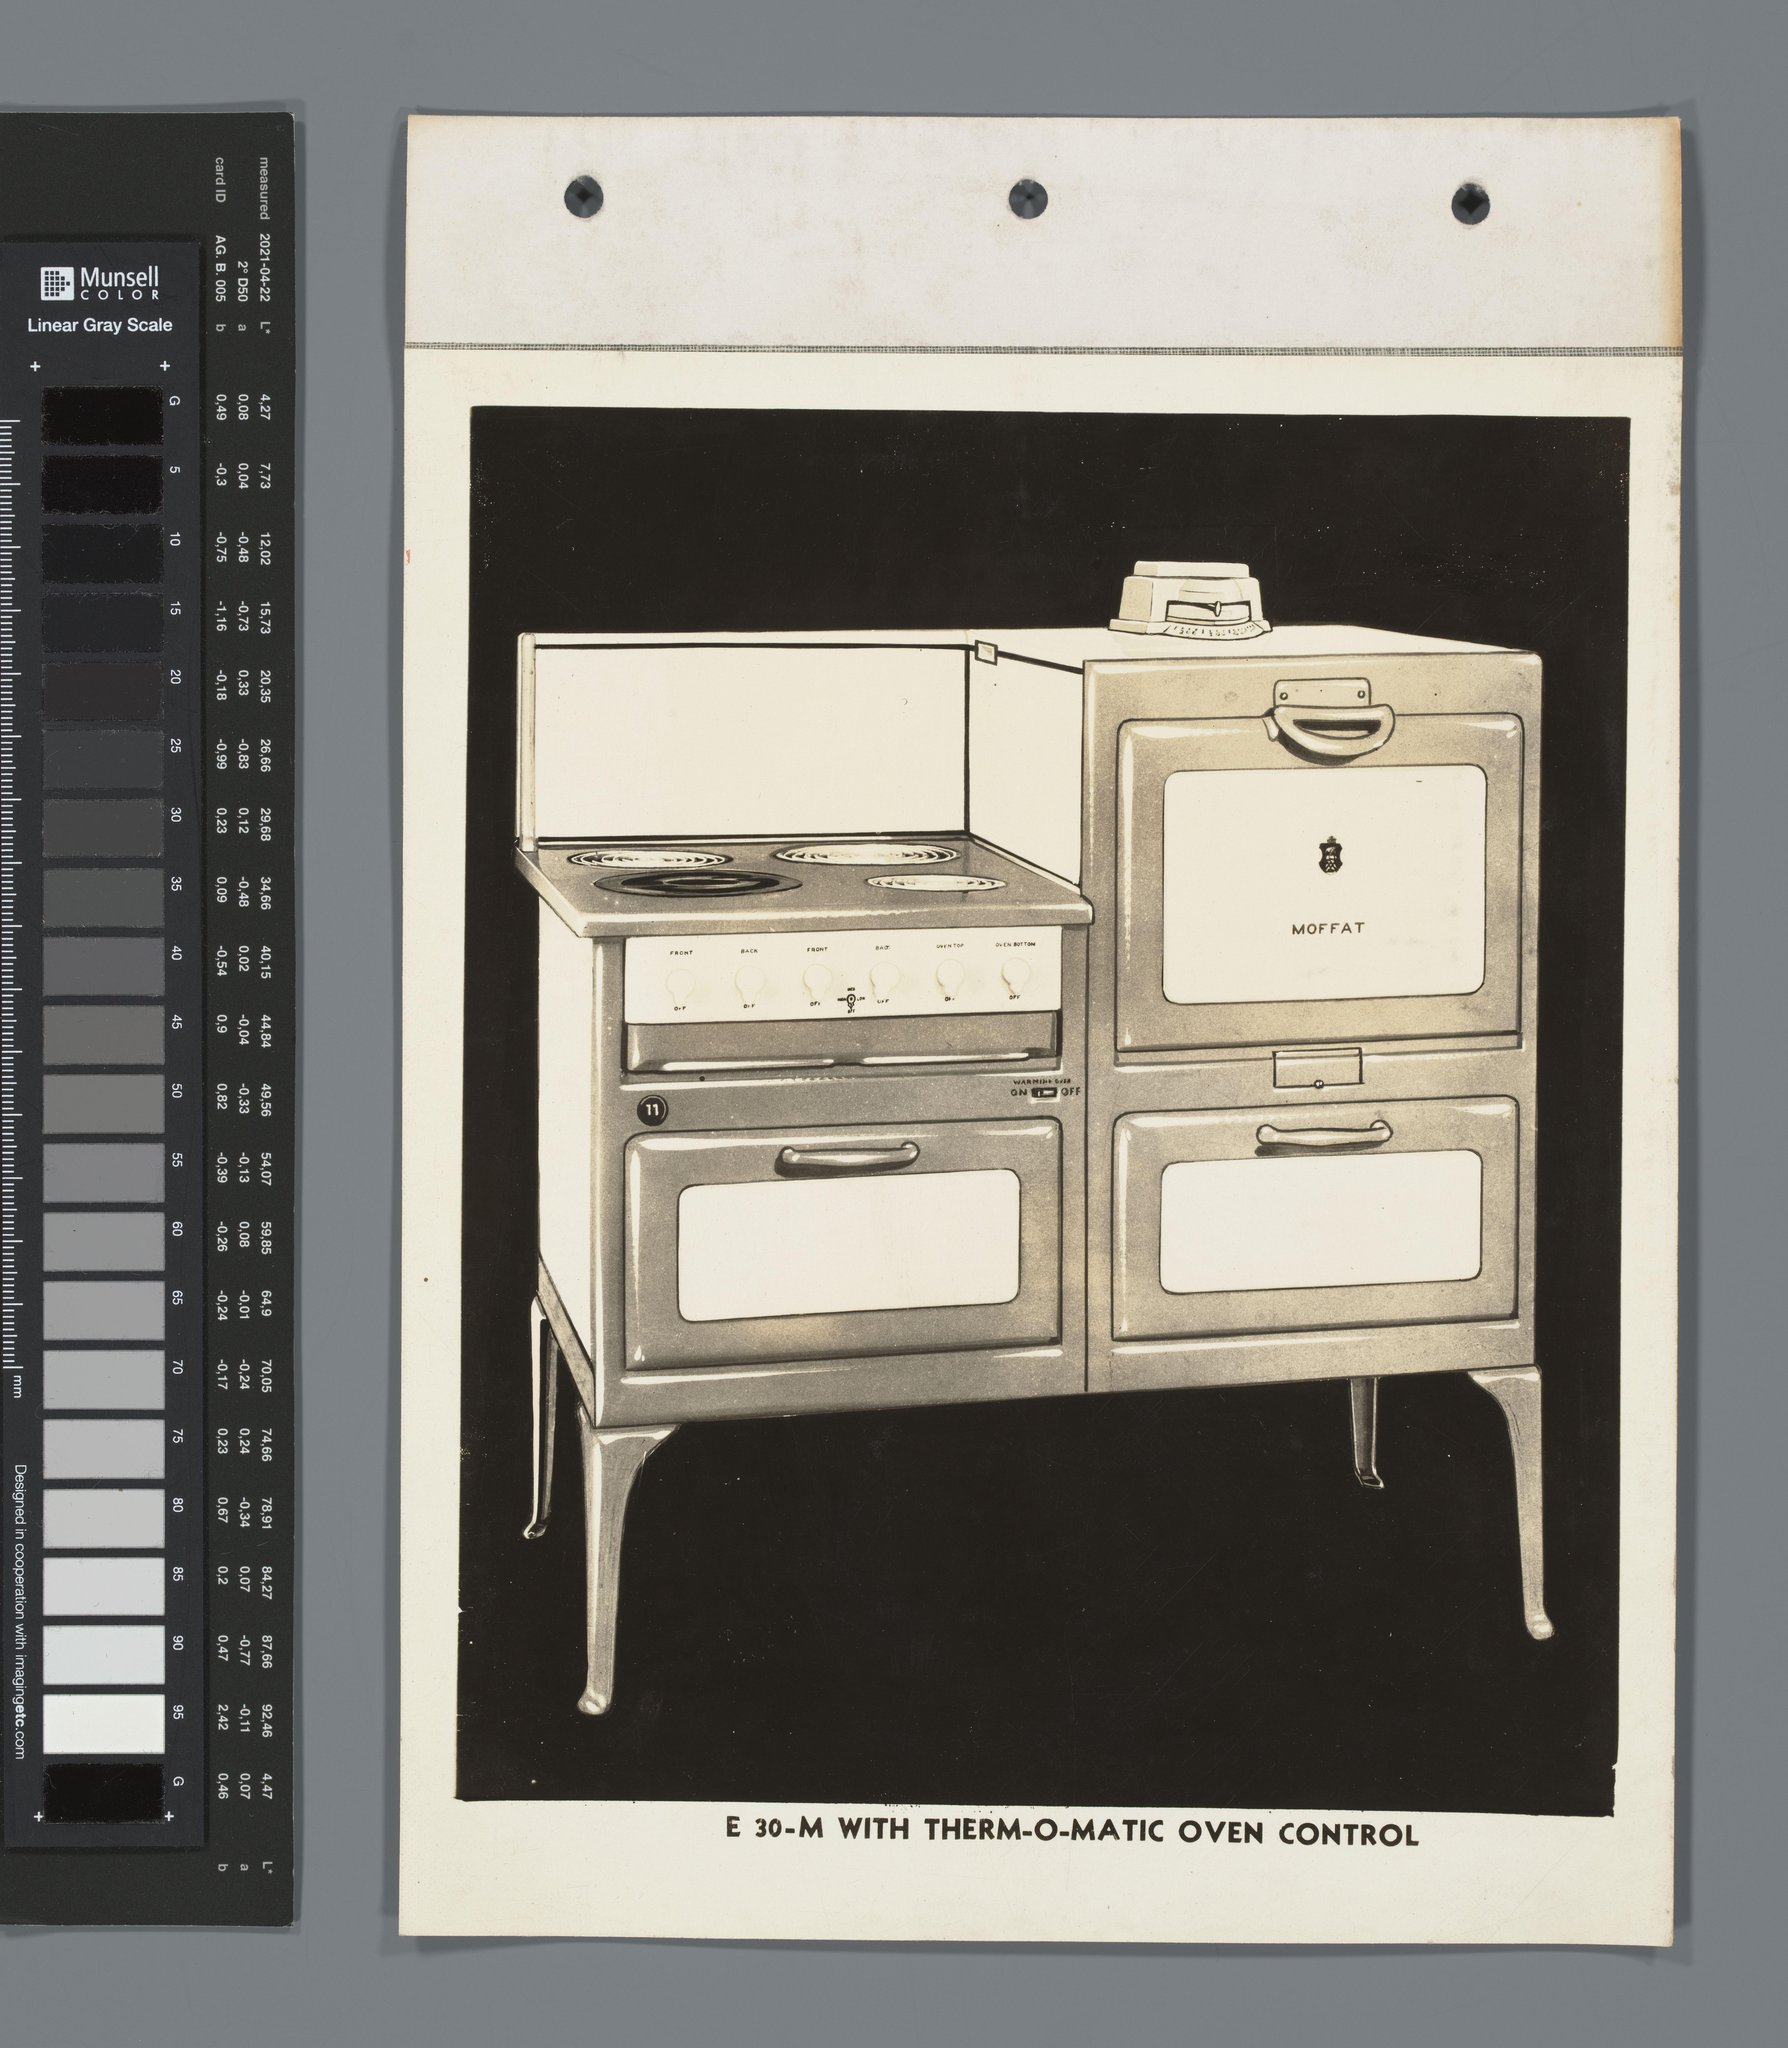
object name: photograph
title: Foto van Moffat ovens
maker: Anonymous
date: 1935-1940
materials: paper, photographic support, textile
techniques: gelatin silver print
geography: canada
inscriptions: inscription: ‘E 30-M WITH THE THERM-O-MATIC OVEN CONTROL’, label: ‘FROM PUBLIC UTILITIES COMMISSION E36M. Electric Light Department NAPANEE, ONTARIO To Std - $15400 C - $16200 spec - $. 16600 Complete with Automatic Oven Control. Via Date’